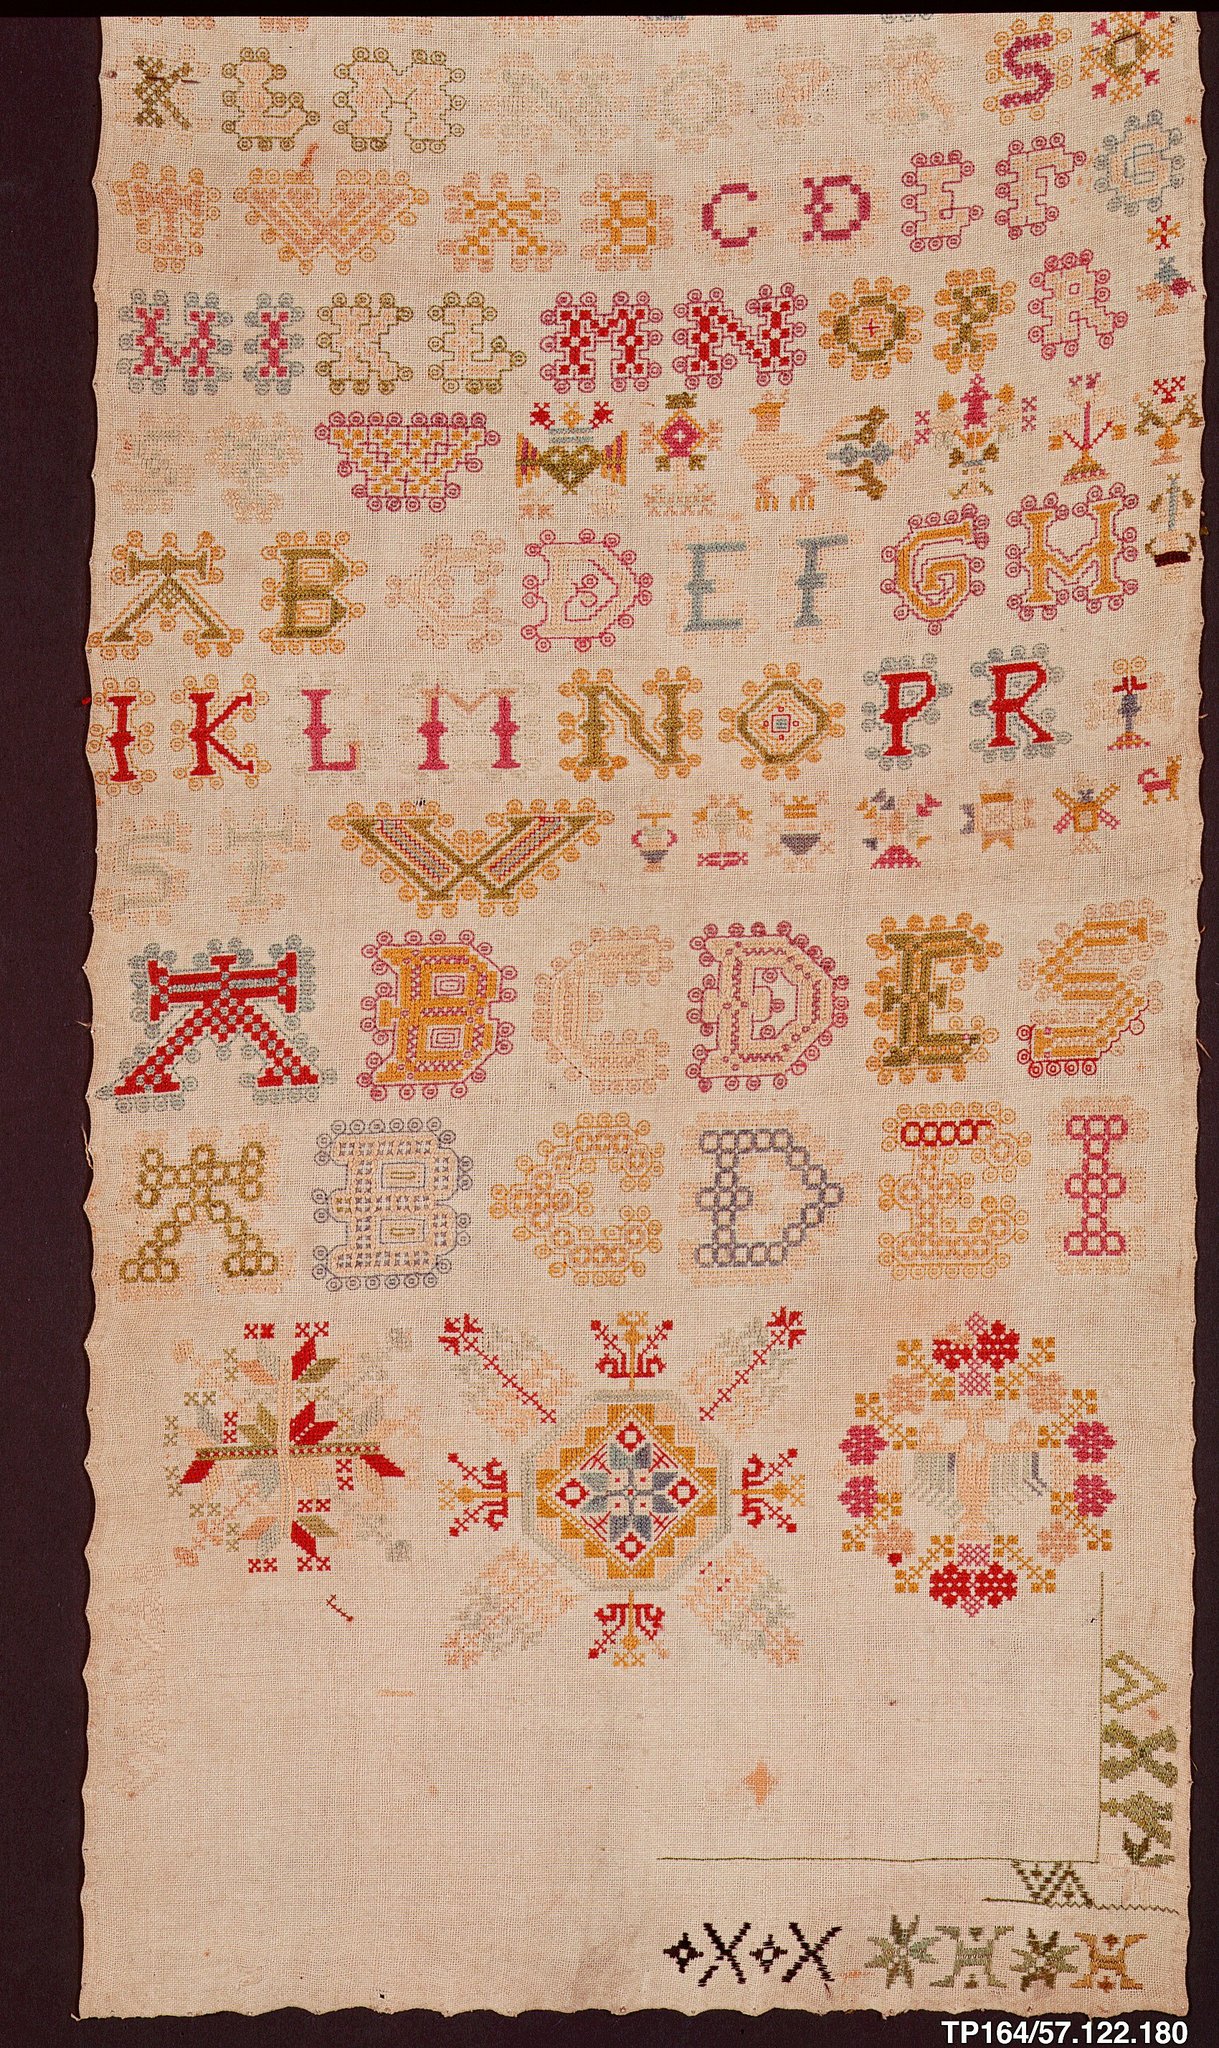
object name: sampler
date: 1701-1800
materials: linen, silk